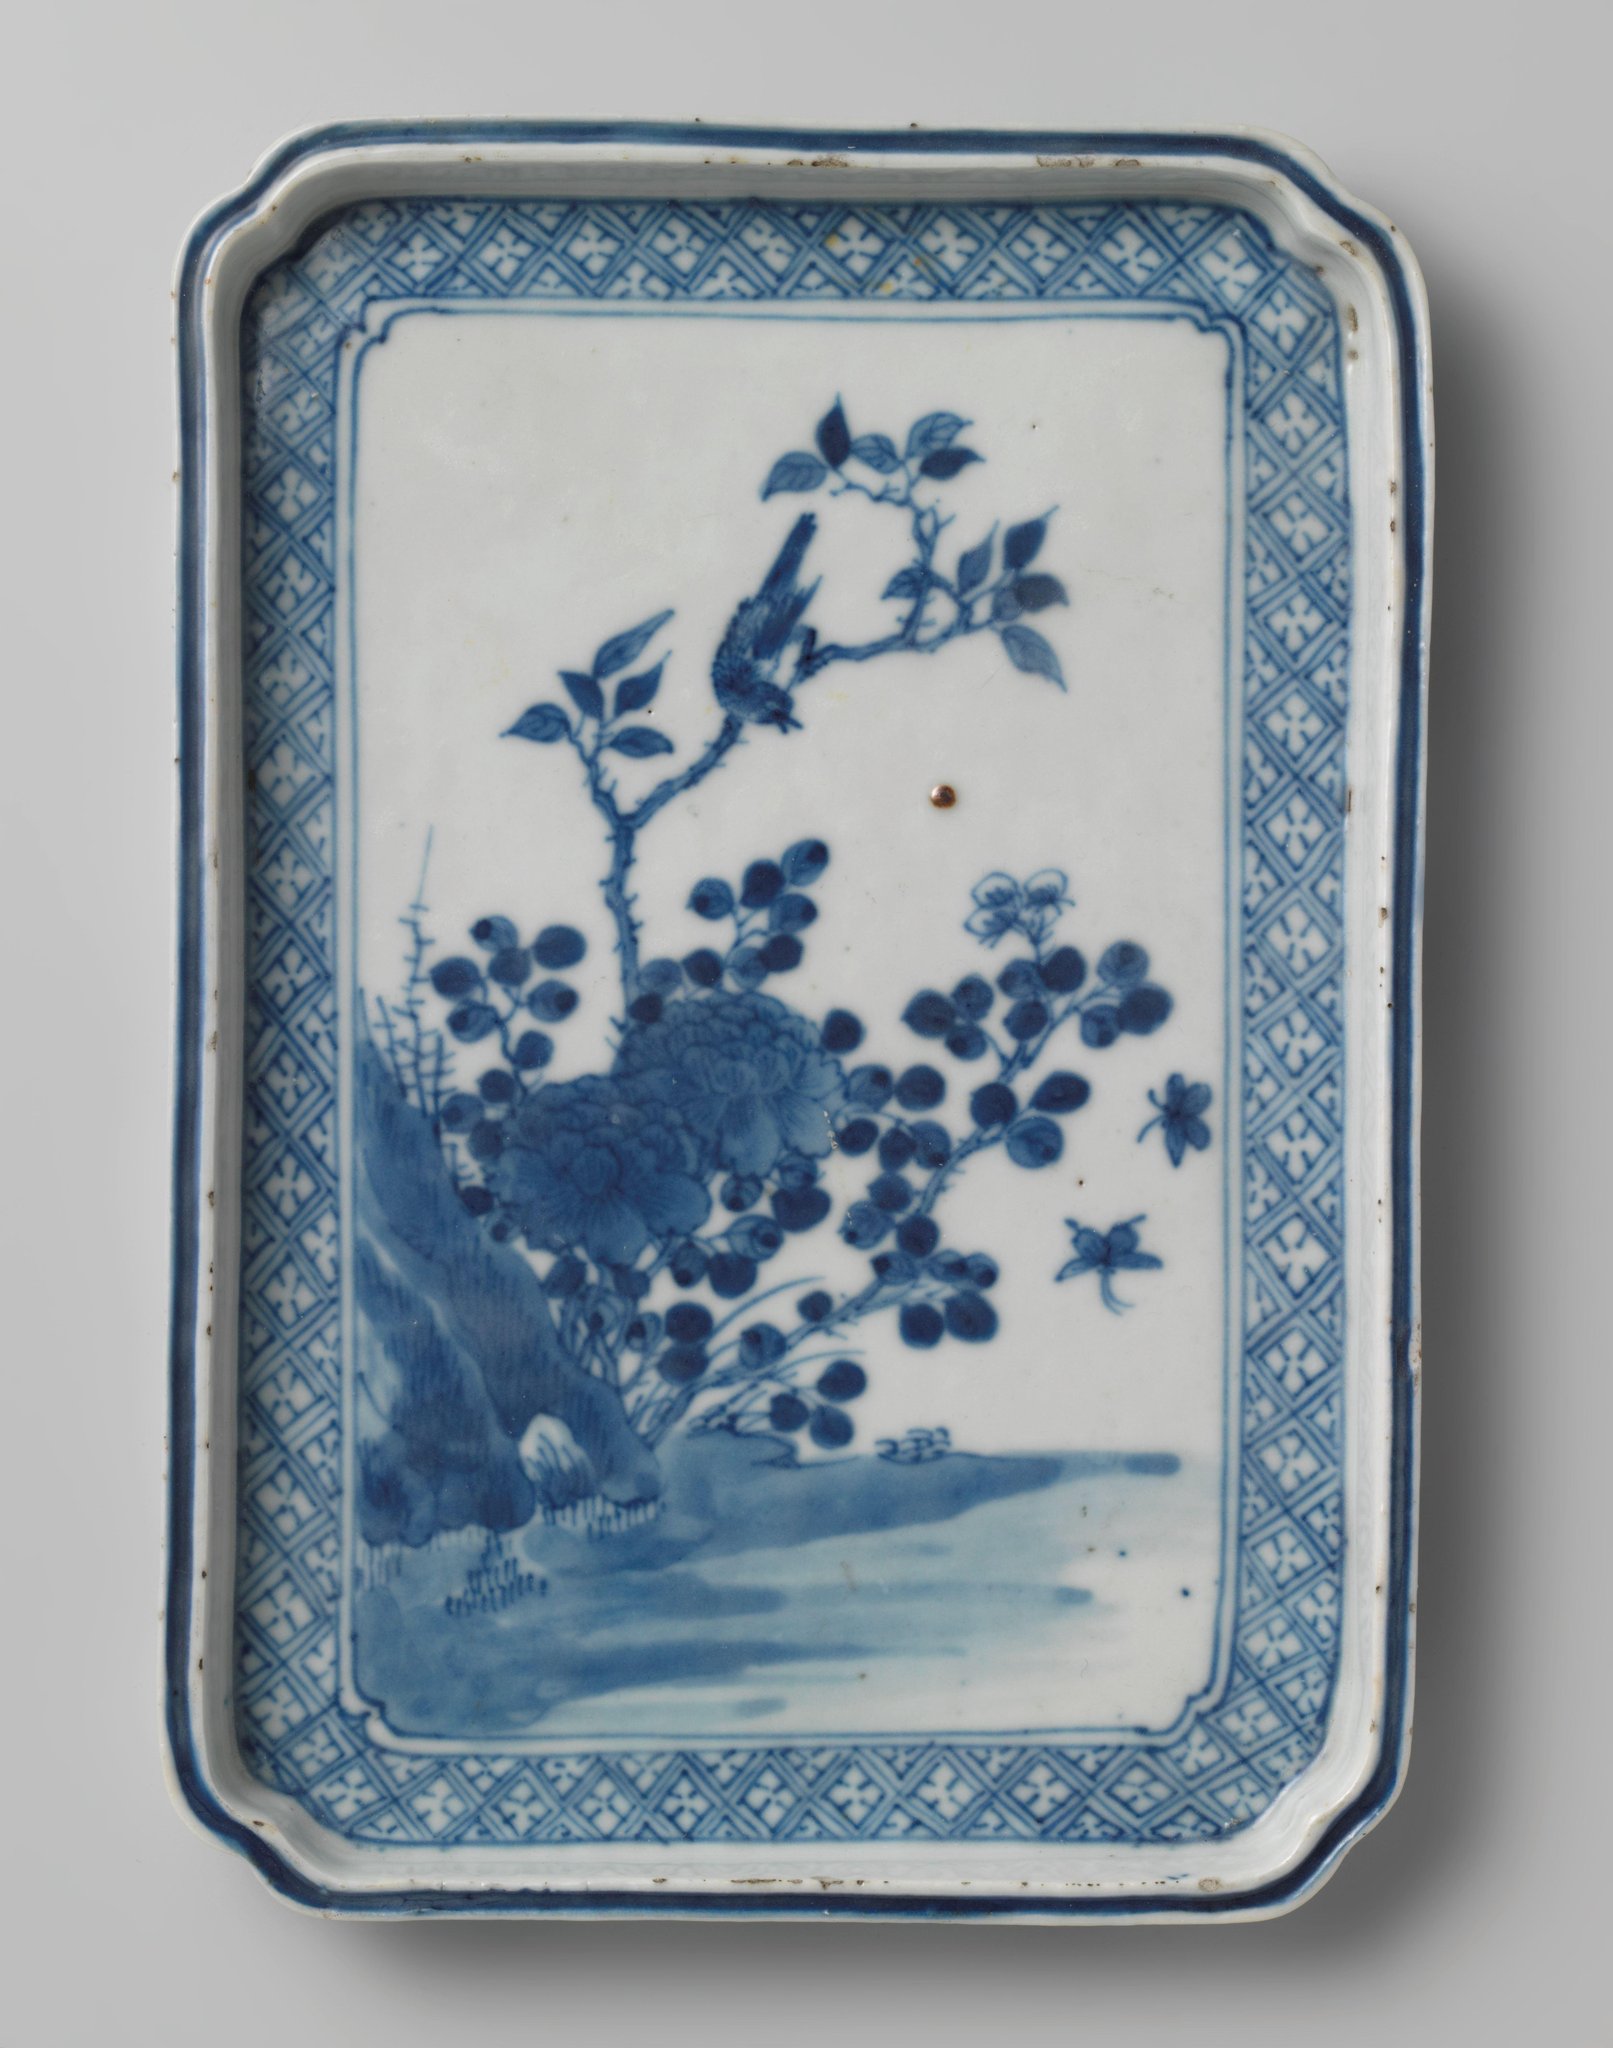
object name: dish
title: Rectangular dish with flowering plants, a bird and insects near a rock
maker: Anonymous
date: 1700-1799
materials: cobalt, glaze, paint, porcelain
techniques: firing, forming, vitrification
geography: arita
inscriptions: label: ‘legaat mevrouw A.M. Kickhefer/ Japan, Arita, 18e eeuw/ 1967’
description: Ondiepe, rechthoekige schaal van porselein met ingeknepen hoeken, beschilderd in onderglazur blauw. Op het plat een vogel op de tak van een bloeiende plant (pioen) en twee vlinders bij een rots. Hieromheen een band met servetwerk. De buitenwand met een blauwe band met prunusbloemen in reserve. De onderzijde is ongeglazuurd. Oud label op de onderzijde met 'legaat mevrouw A.M. Kickhefer/ Japan, Arita, 18e eeuw/ 1967'. Arita, blauw-wit.